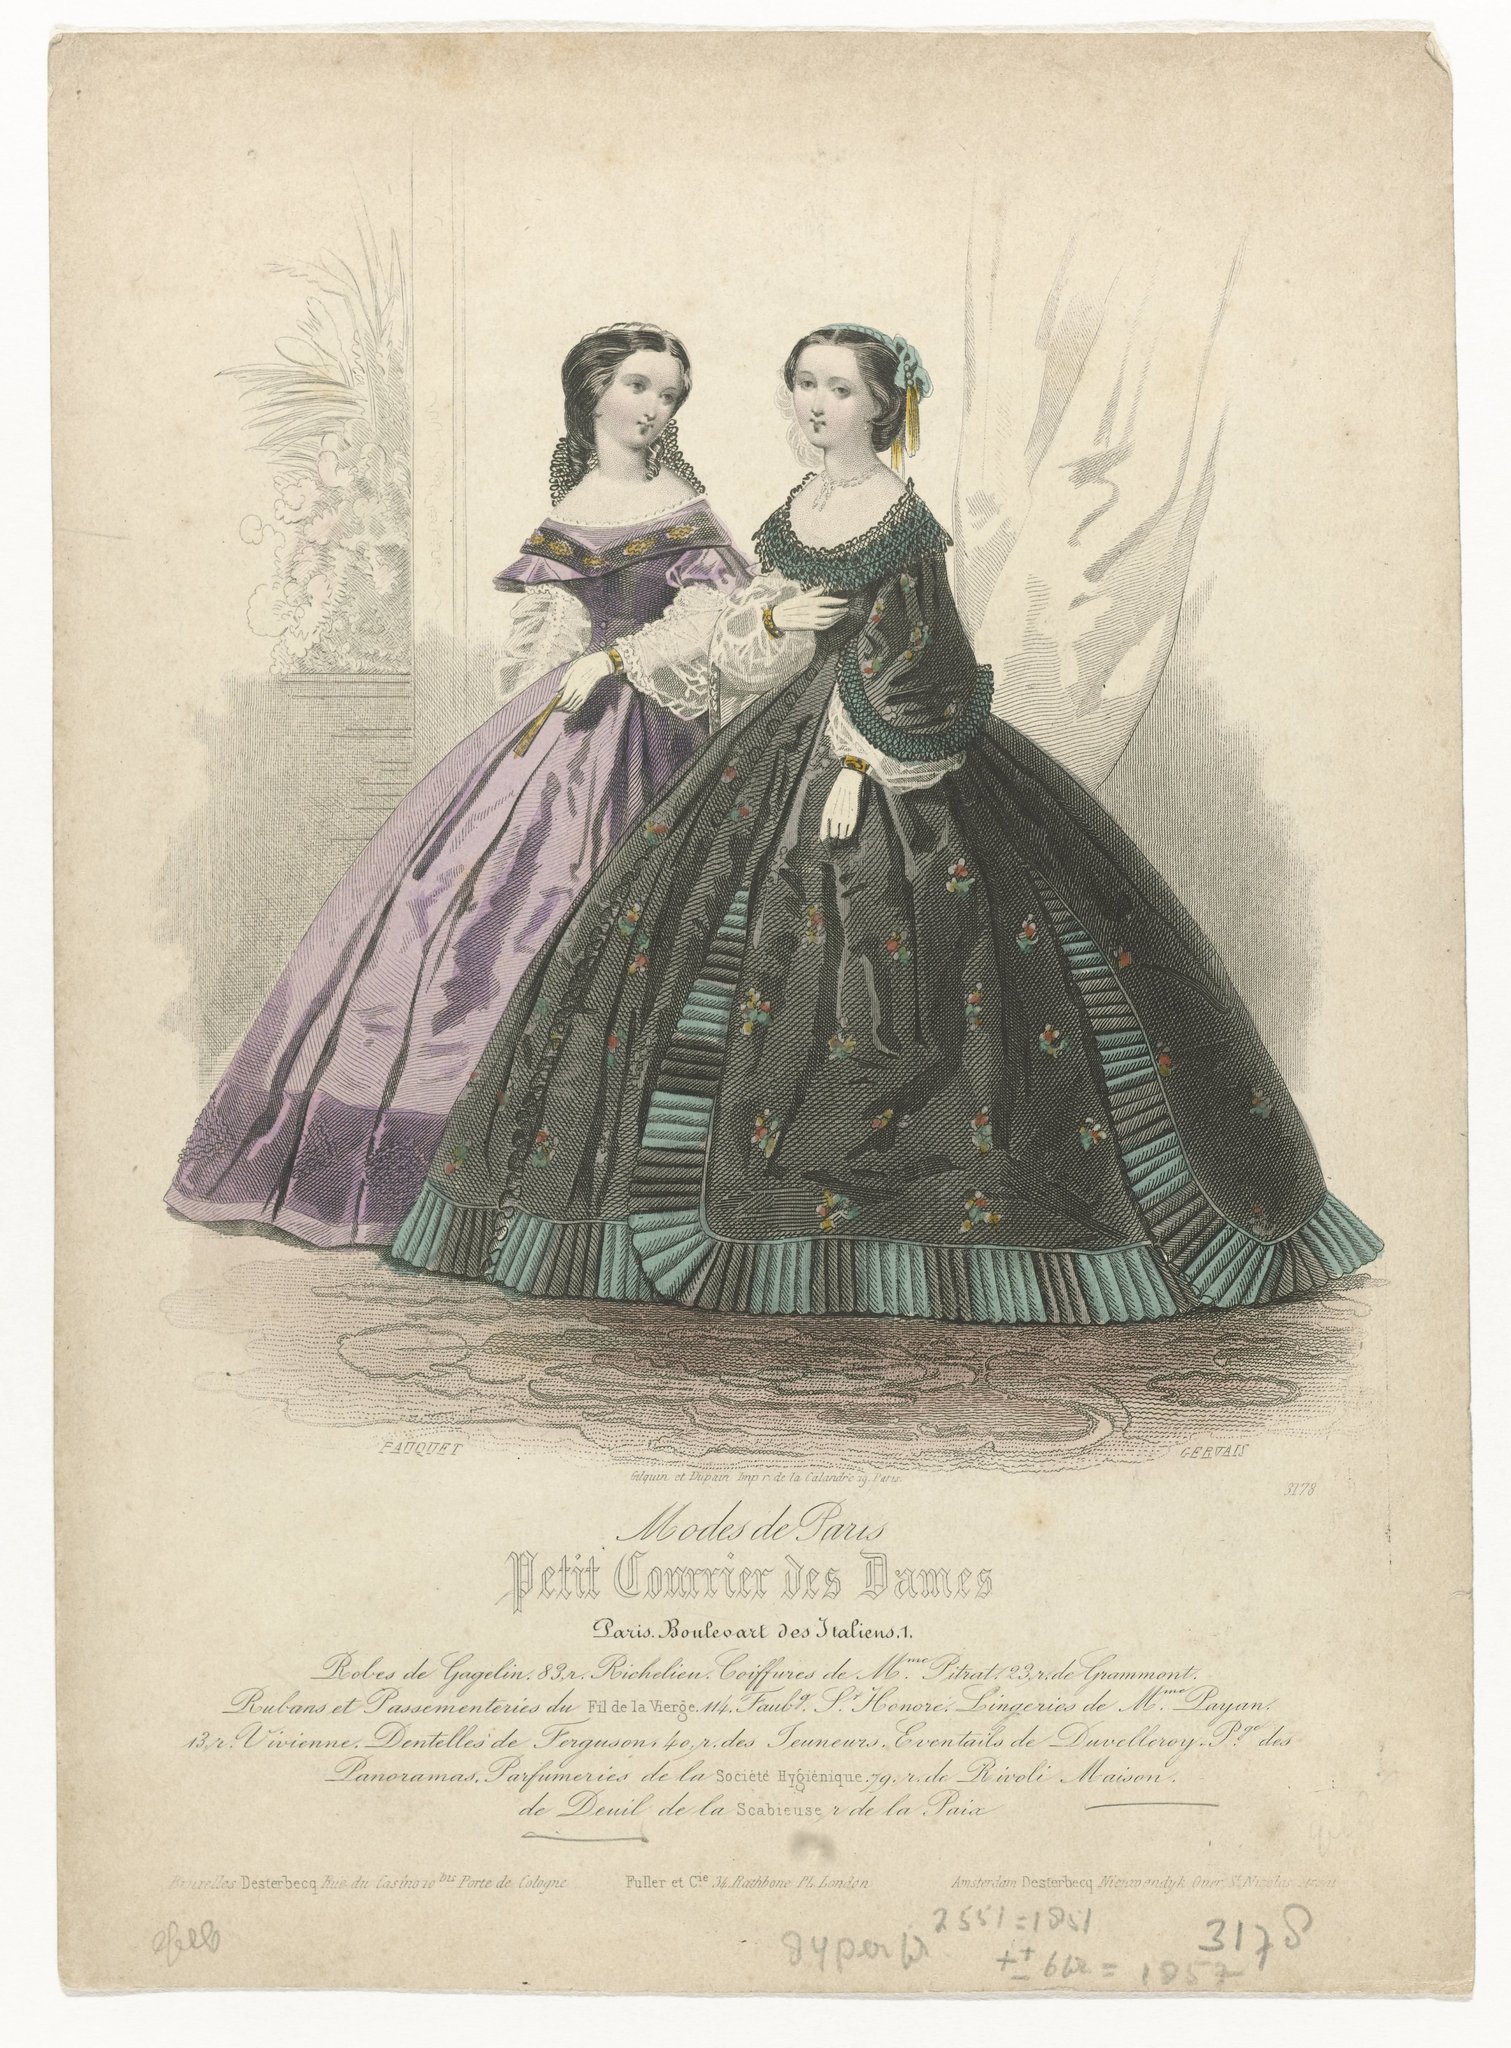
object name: fashion print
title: Petit Courrier des Dames, 1857, No. 3178 : Robes de Gagelin (...)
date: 1857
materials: paper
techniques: engraving, hand coloring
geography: paris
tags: ear-rings (+ women's clothes), ornamental parts of clothing (+ women's clothes), border, ribbon, braid (+ women's clothes), lace (+ women's clothes), styles of hairdress - aa - ~ women, fashion plates, gloves, mittens, etc. (+ women's clothes), fan (+ women's clothes), bracelet, wristlet (+ women's clothes), necklace (+ women's clothes)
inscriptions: address: ‘Paris, Boulevart des Italiens, 1. / Bruxelles Deterbecq Rue du Casino 10 bis Porte de Cologne / Fuller et Cie, 34 Rathbone Pl. London / Amsterdam Desterbecq Nieuwendijk Over St Nicolas Straat’, title: ‘Modes de Paris / Petit Courrier des Dames’, caption: ‘Robes de Gagelin. 83, r. Richelieu. Coiffures de M.me Pitrat, 23, r. de Grammont. Rubans et Passementeries du Fil de la Vierge, 114, Faub.g S.t Honoré. Lingeries de M.me Payan. 13 r. Vivienne. Dentelles de Ferguson, 40, r. des Jeuneurs. Eventails de Duvelleroy, P.ge des Panoramas. Parfumeries de la Société Hygiénique, 79, r. de Rivoli Maison de Deuil de la Scabieuse r de la Paix’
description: Twee vrouwen in een interieur. Volgens het onderschrift: japonnen van Gagelin. 'Coiffures' van Pitrat. Hieronder enkele regels reclametekst voor verschillende producten. Prent uit het modetijdschrift Petit Courrier des Dames (1821-1868).